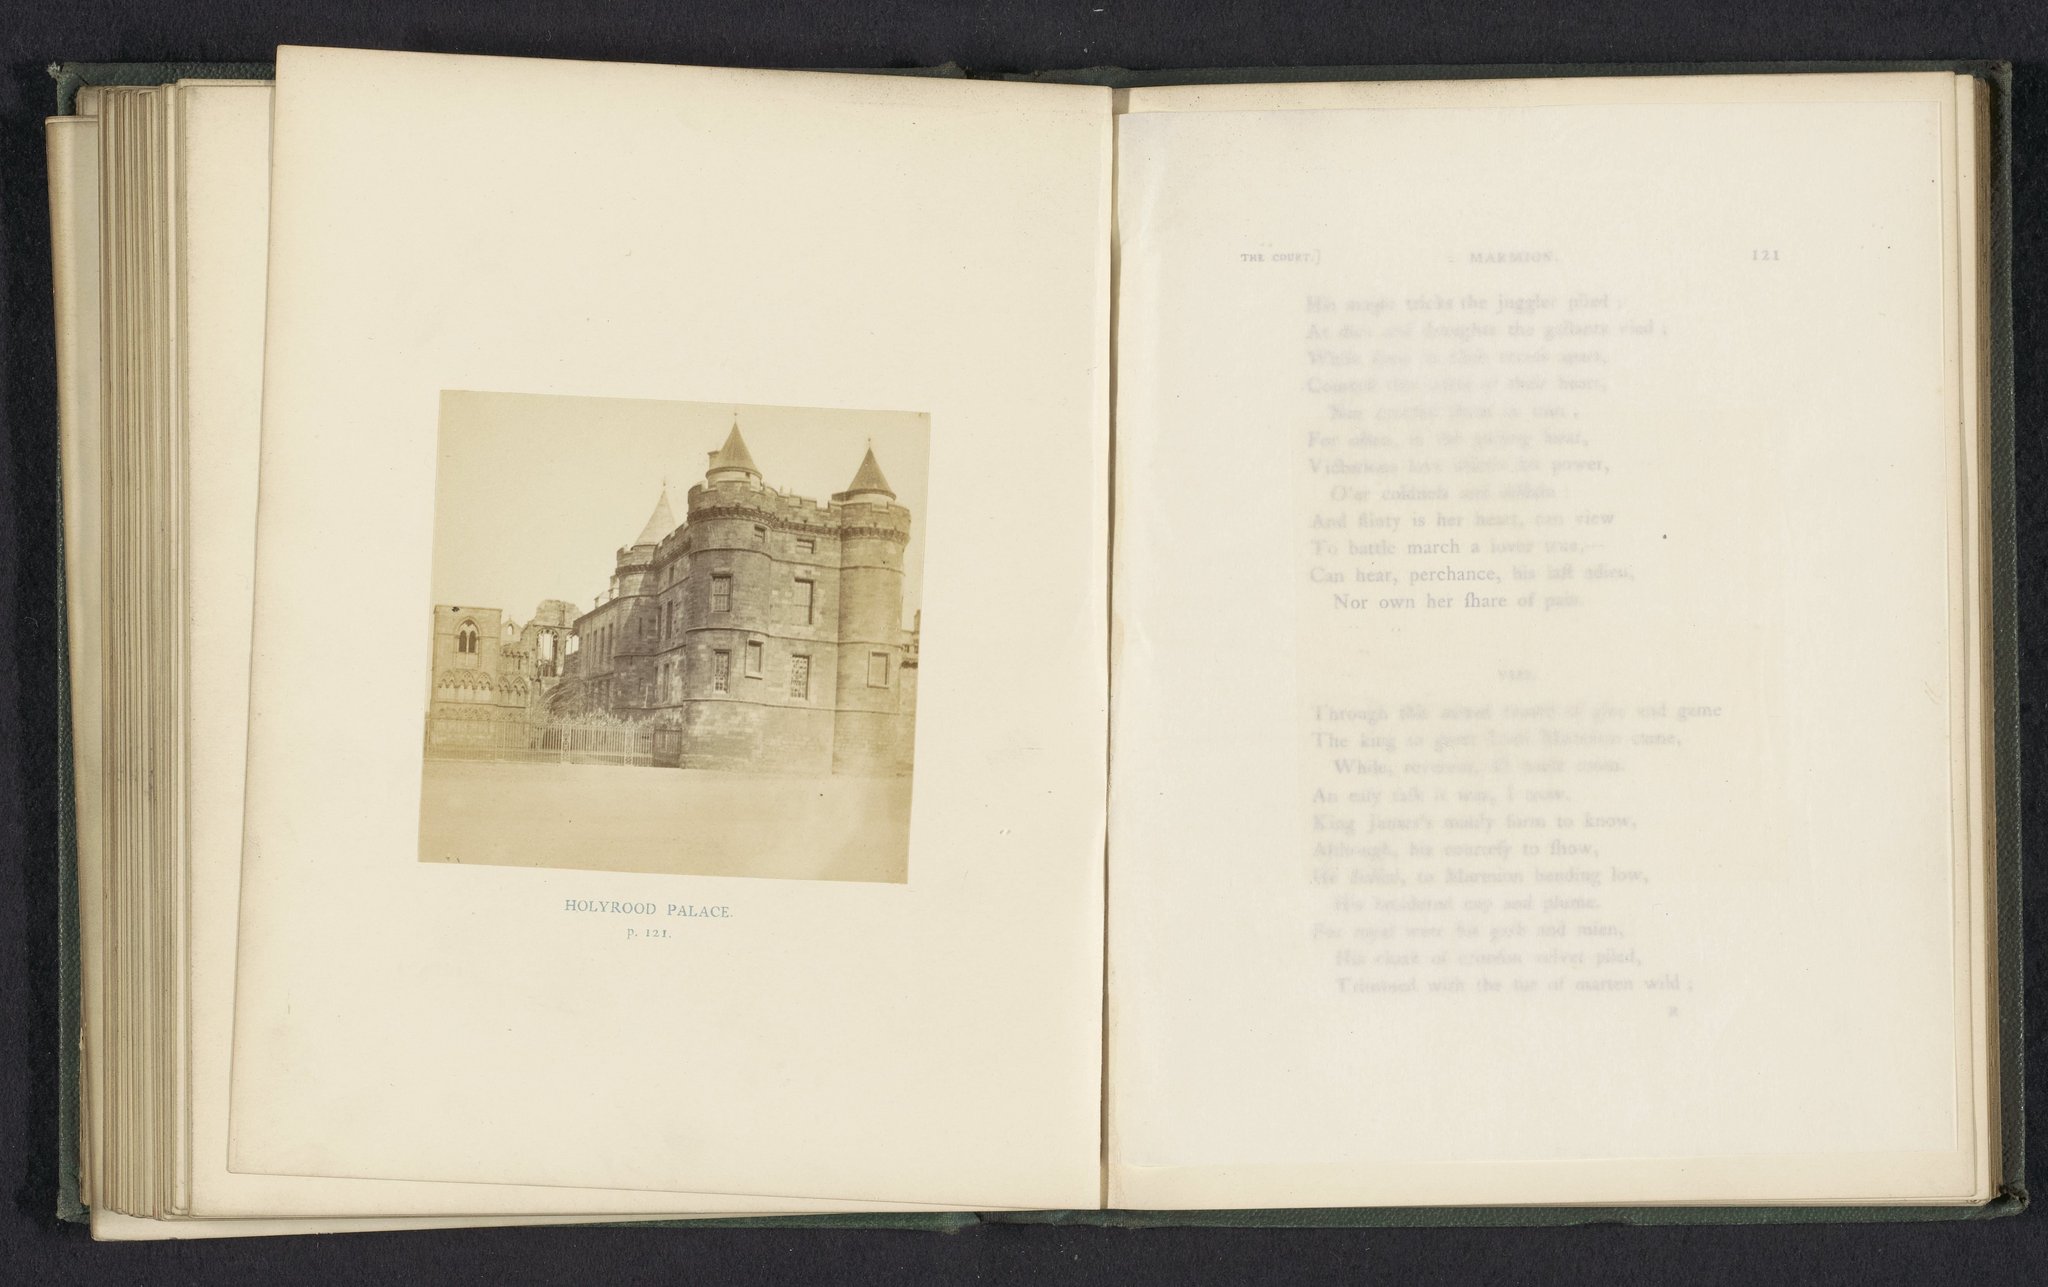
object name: page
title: Holyrood Palace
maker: thomas annan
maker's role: fotograaf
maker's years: 1829-1887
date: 1861-1866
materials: photographic support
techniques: albumen print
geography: edinburgh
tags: castle, façade (of house or building)